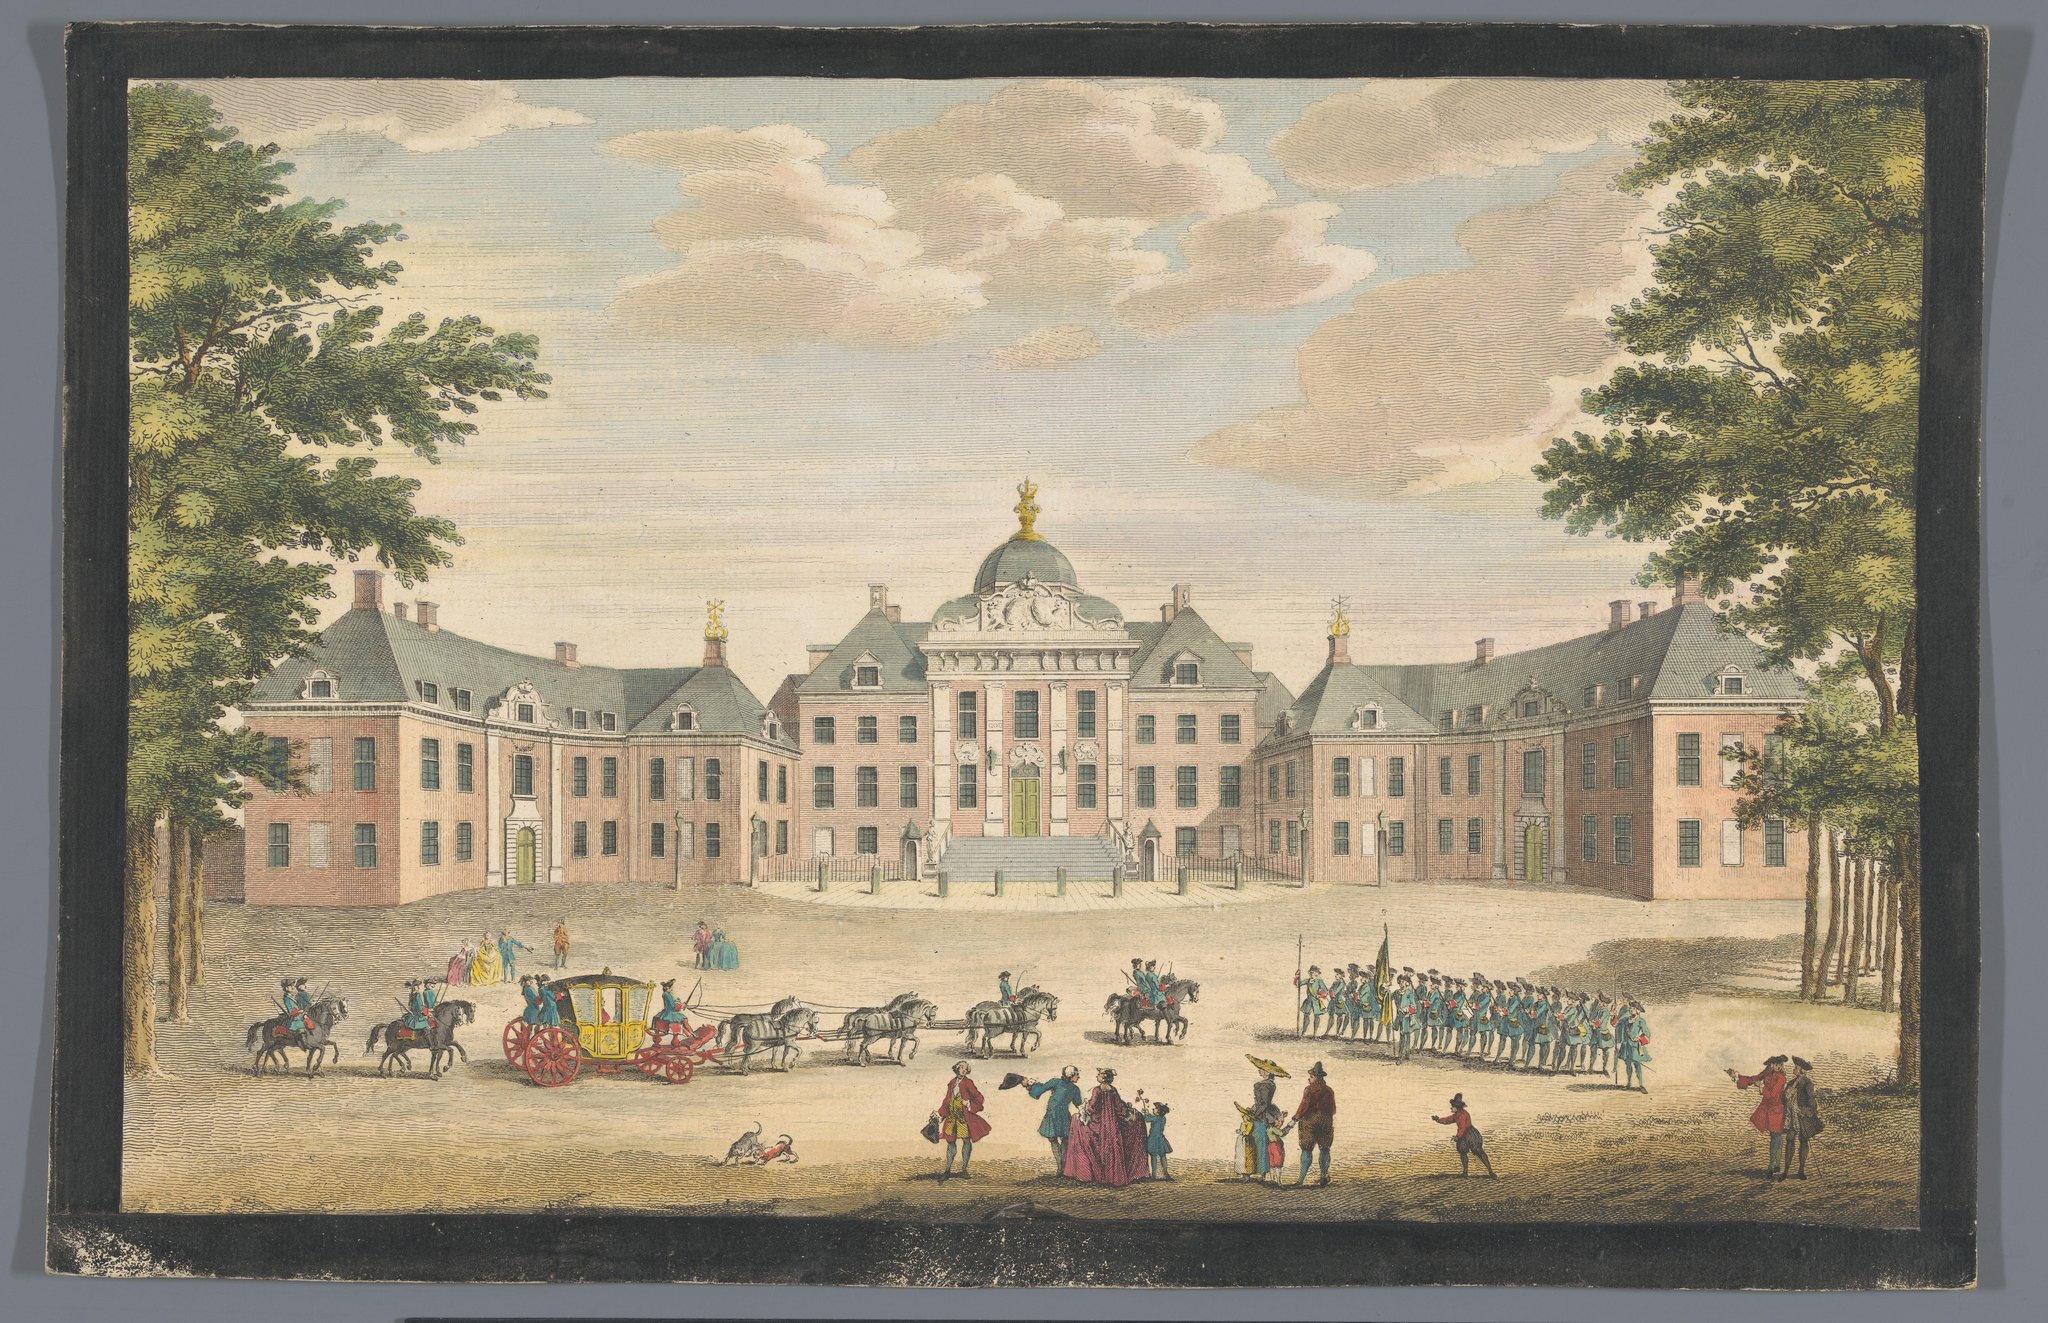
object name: opticaprent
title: A front view of the prince of Orange's house in the wood near The Hague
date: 1745-1794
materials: cardboard, paper, watercolor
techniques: brush, etching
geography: netherlands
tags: palace, four-wheeled vehicle drawn by more than three animals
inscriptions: inscription: ‘Fo 28 B4’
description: Links rijdt een koets getrokken door zes paarden.